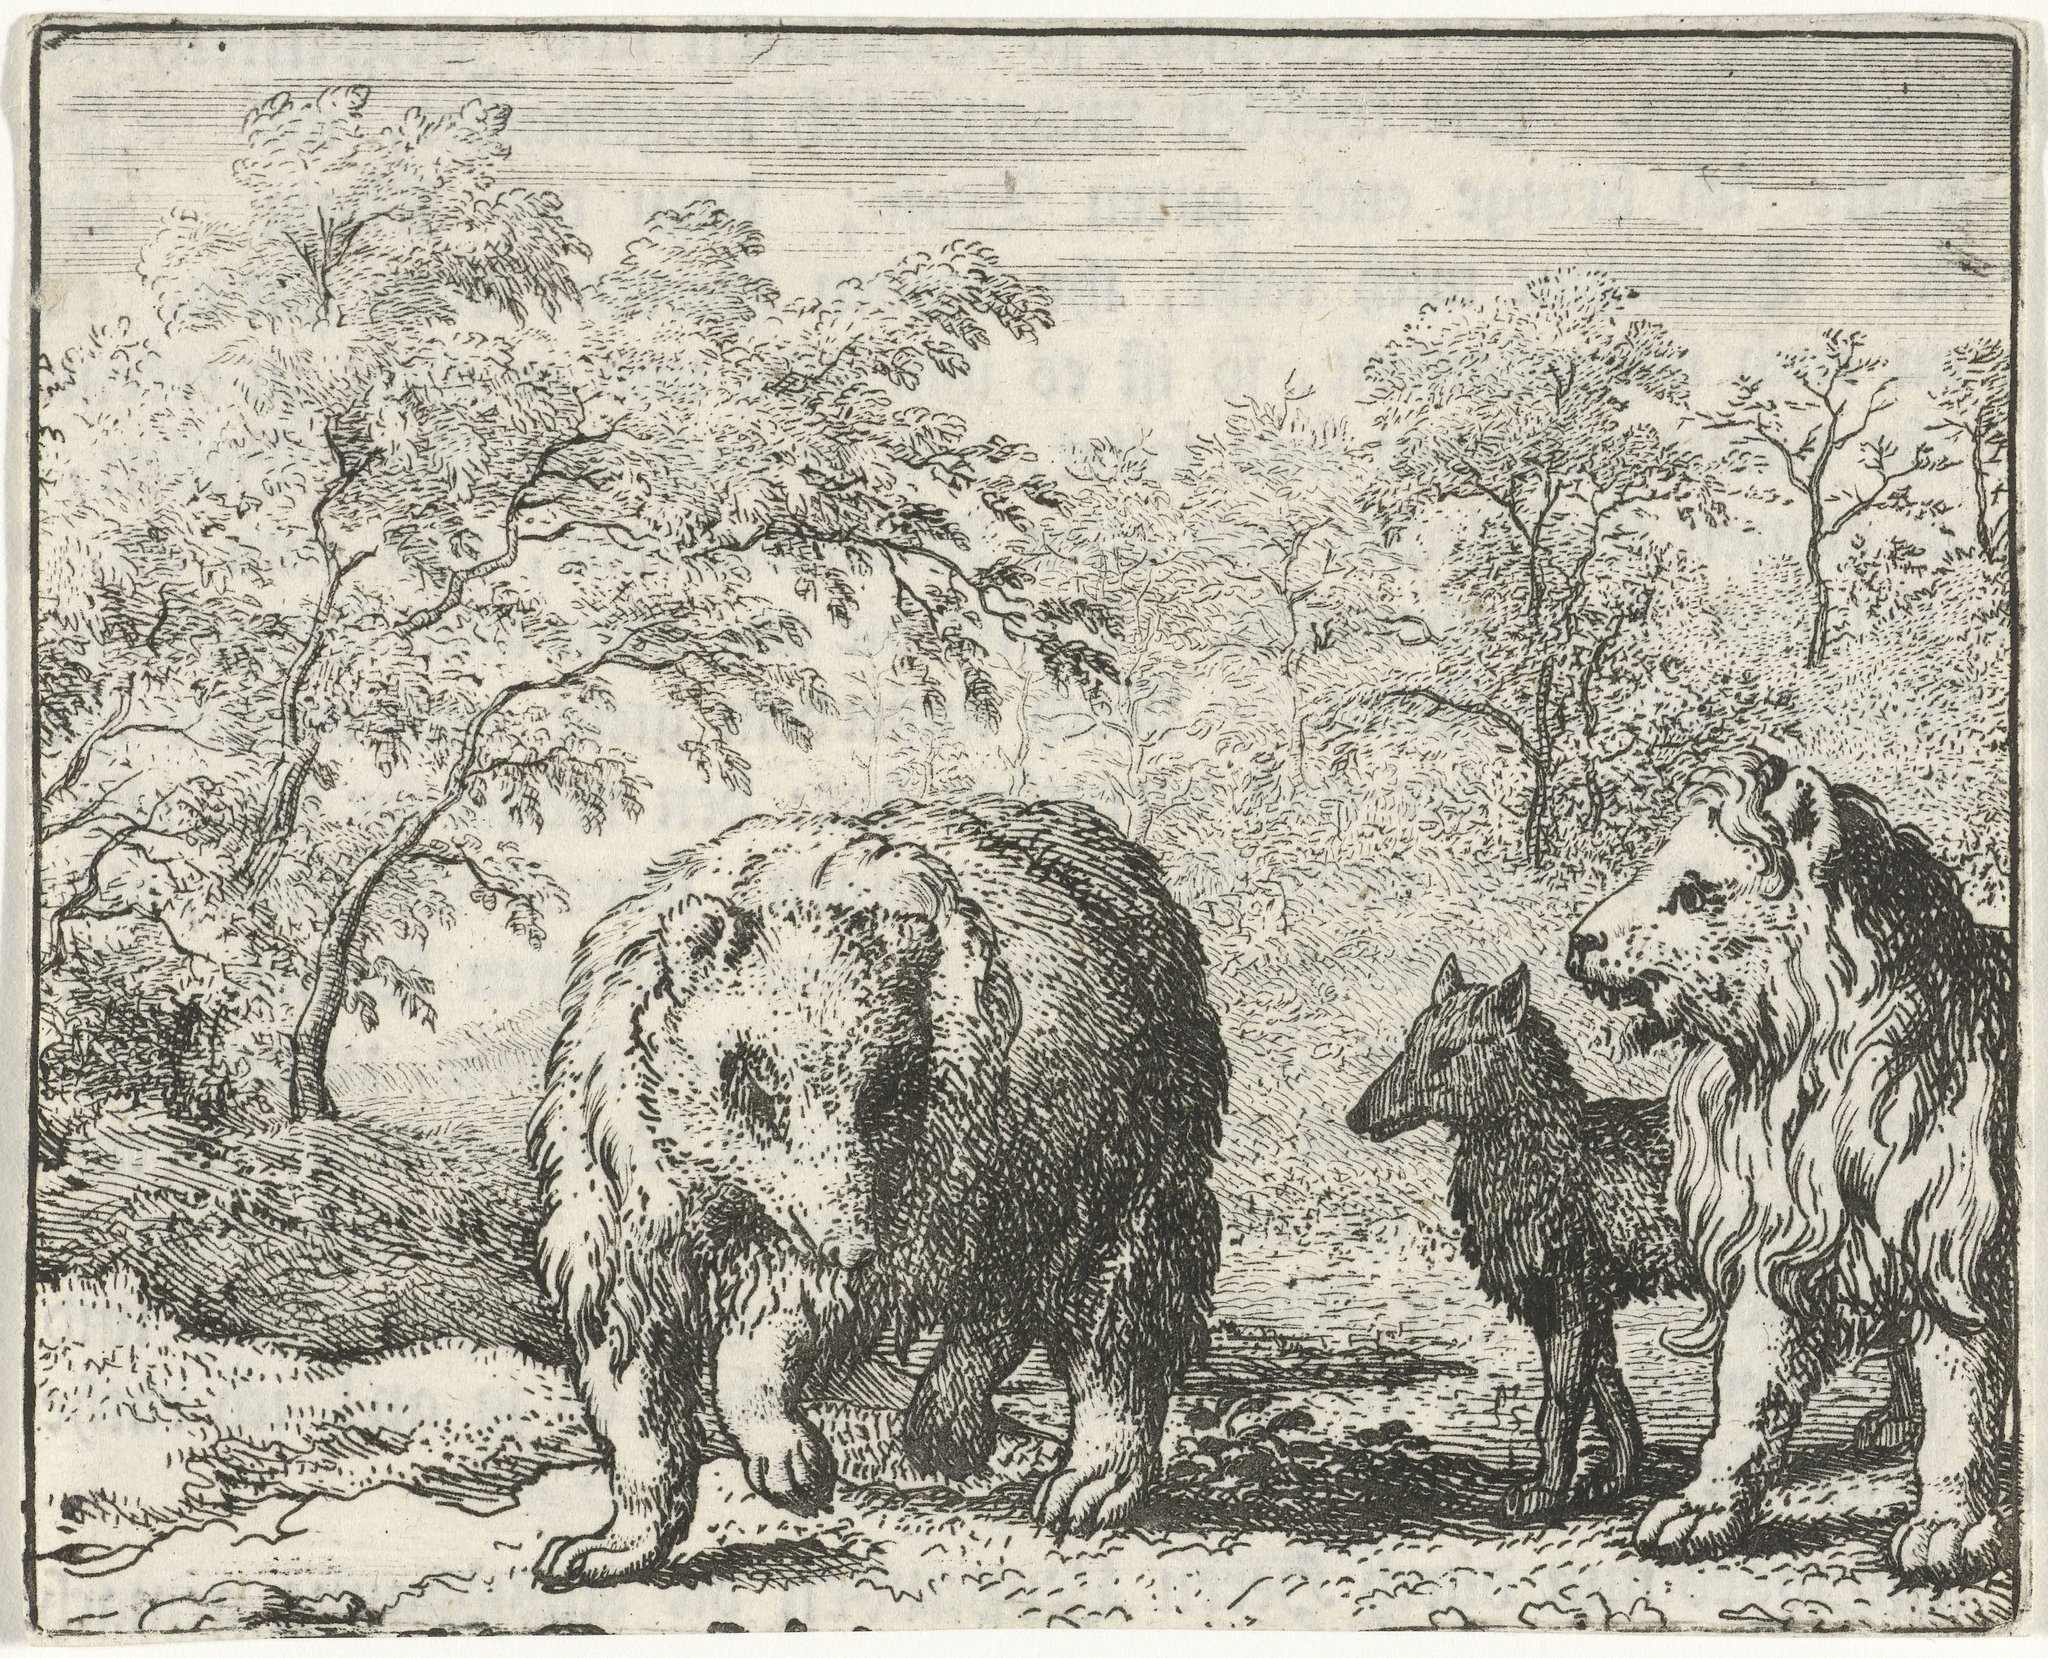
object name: book illustration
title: Reinaert de vos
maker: allaert van everdingen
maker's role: draughtsman, painter, print maker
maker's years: 1621-1675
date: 1665-1675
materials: paper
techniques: etching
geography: netherlands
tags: fable of reynard the fox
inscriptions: collector's mark: Lugt 2228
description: Landschap met Bruun de beer, Isengrijn de wolf en koning Nobel de leeuw. Op de achterkant van de prent een Duits tekstfragment uit het verhaal van Reinaert de vos.